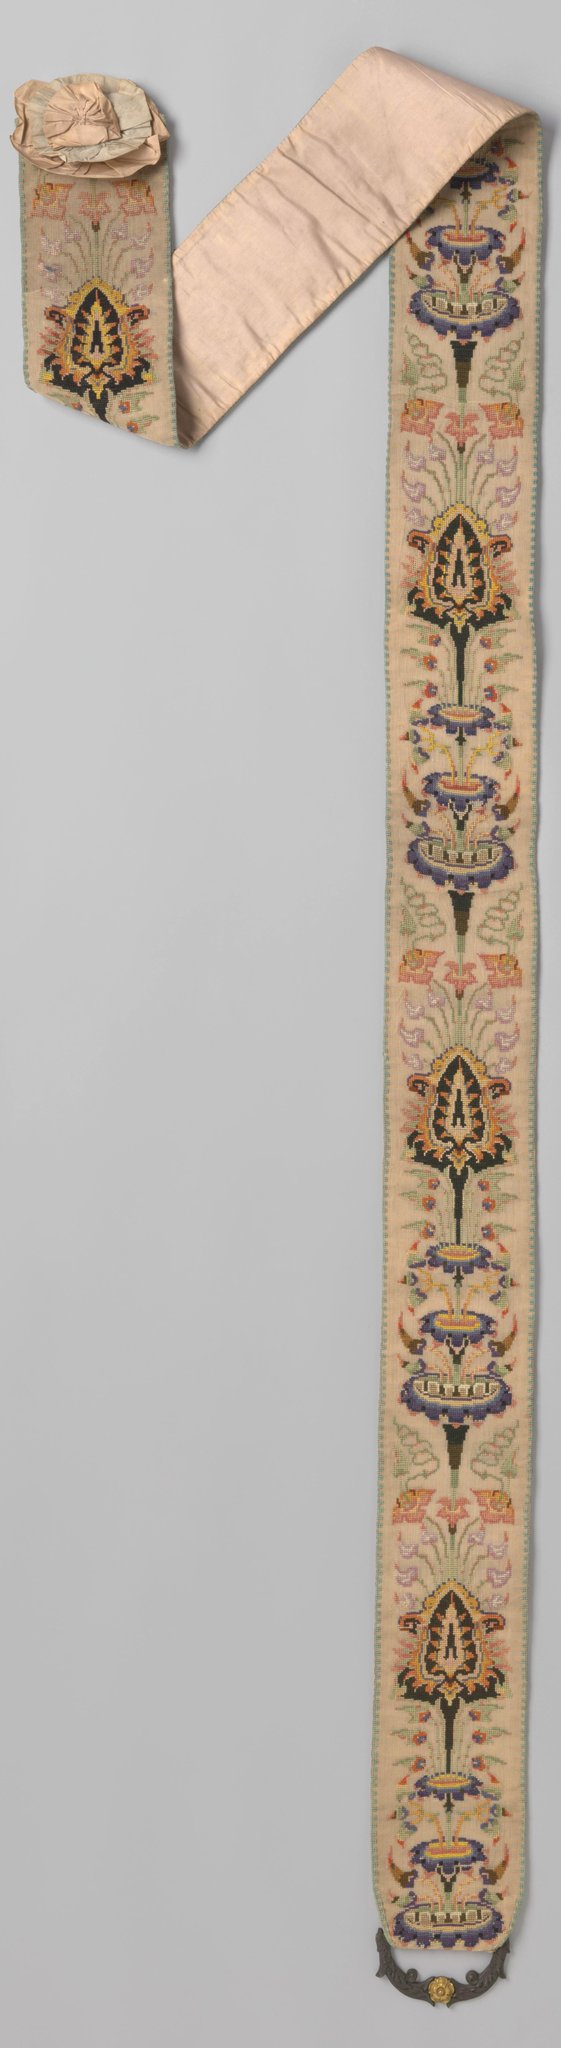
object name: schellekoord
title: Schelkoord met wollen borduursel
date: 1800-1850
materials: bronze, silk, textile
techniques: embroidered, gilding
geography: netherlands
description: Schelkoord met wollen borduursel. Op een vergeeld stramien staat ene zich herhalend candelabre motief. Het koord is gevoerd met fletsrode taftzijde en is afgewerkt met een rozet van rose en witte tafzijde. De greep bestaat uit een donker gepatineerde, deels verguld bronzen halve boog van twee acanthusranken, die uit de hals van een leeuwekop ontspringen en door een verguld rozet gesloten worden.